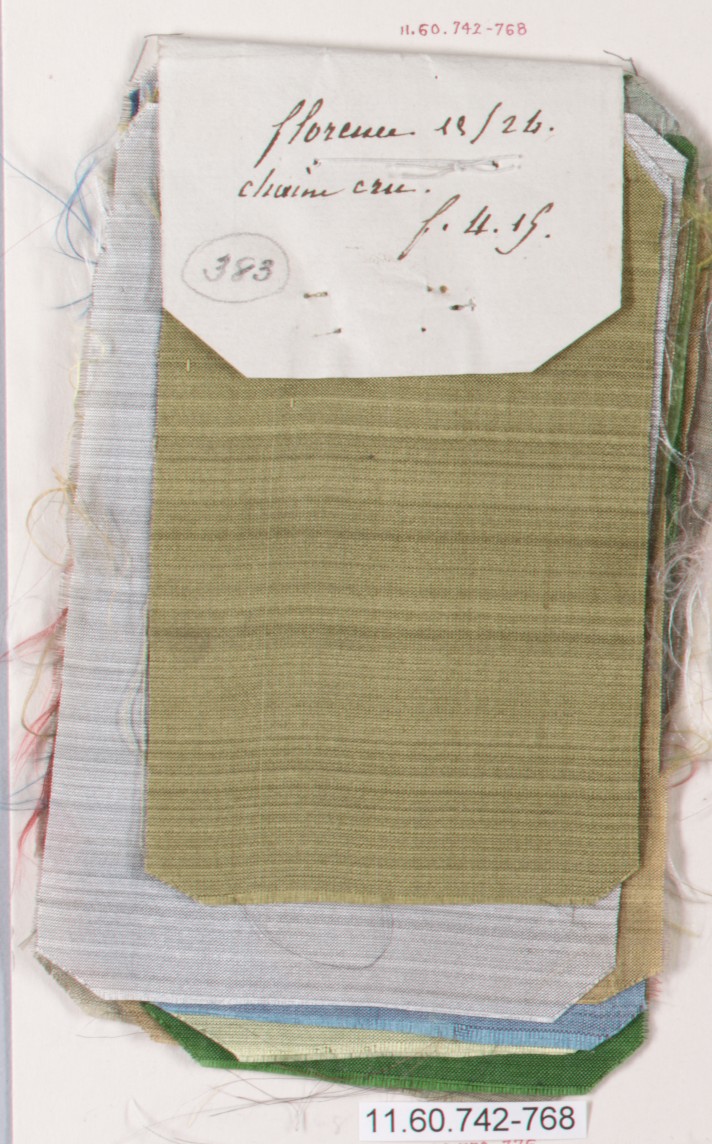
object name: sample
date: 1801-1833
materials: silk